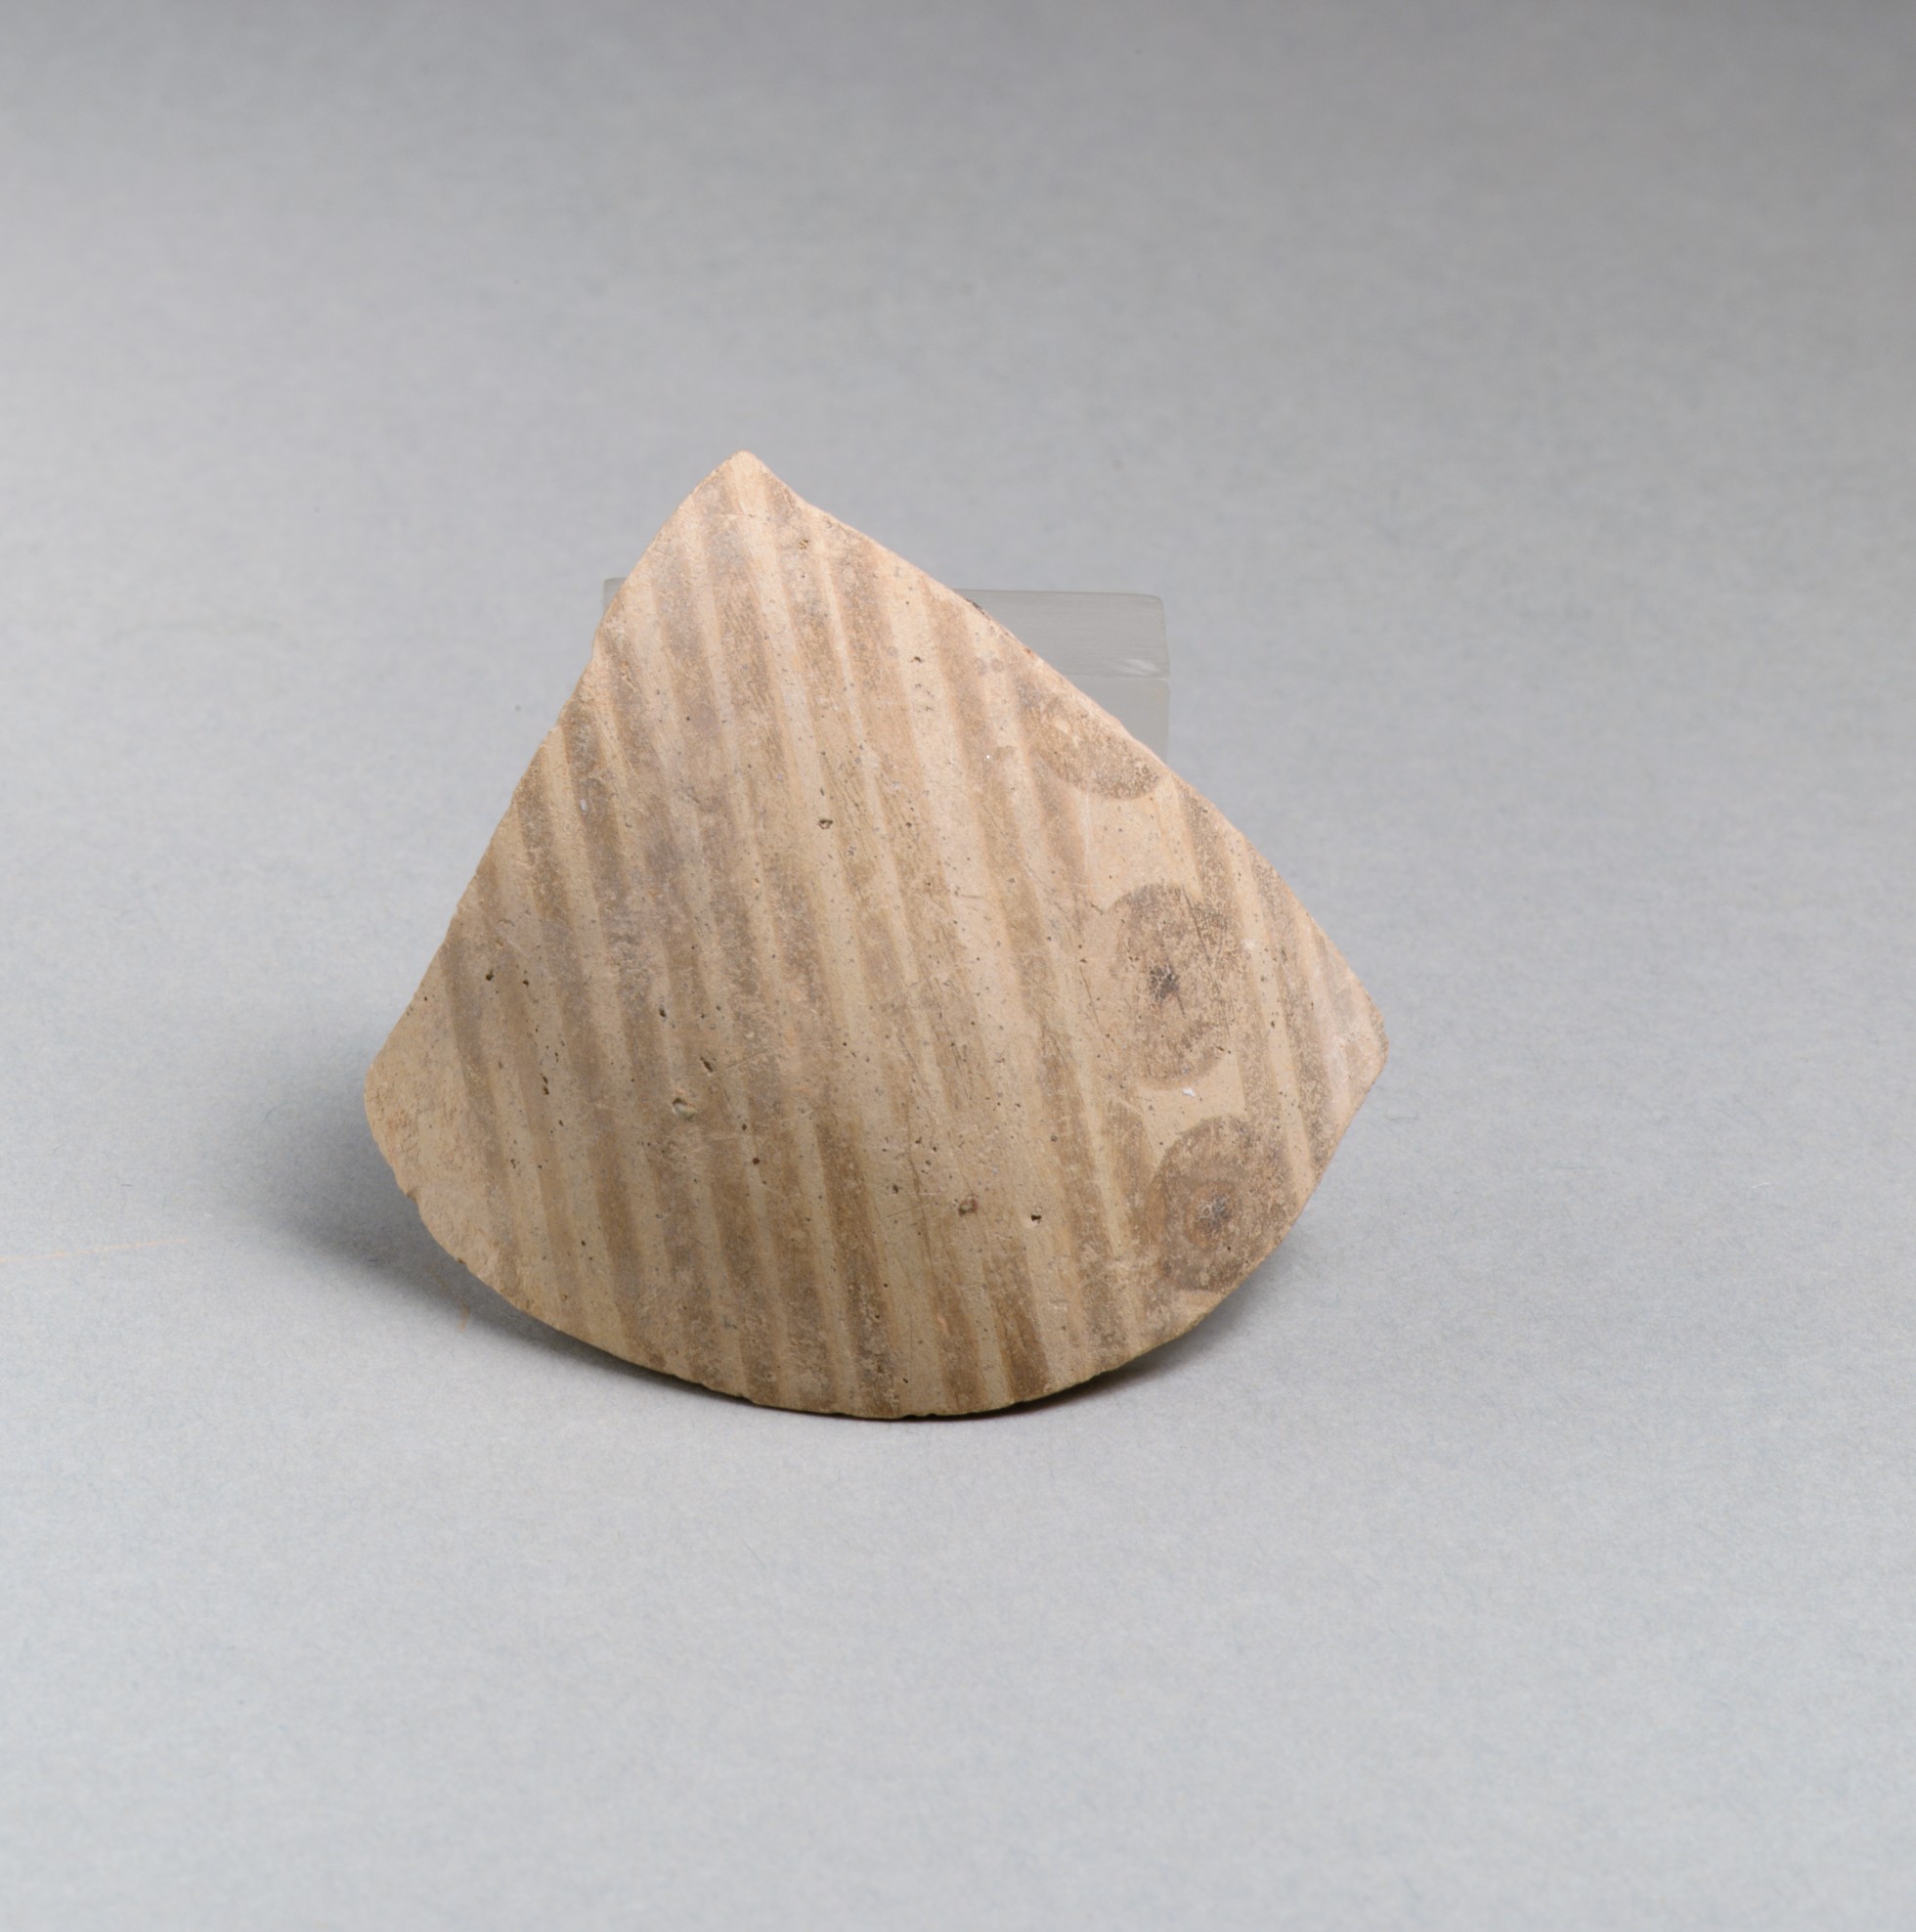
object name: vase fragment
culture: minoan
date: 1600-1450 BCE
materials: terracotta